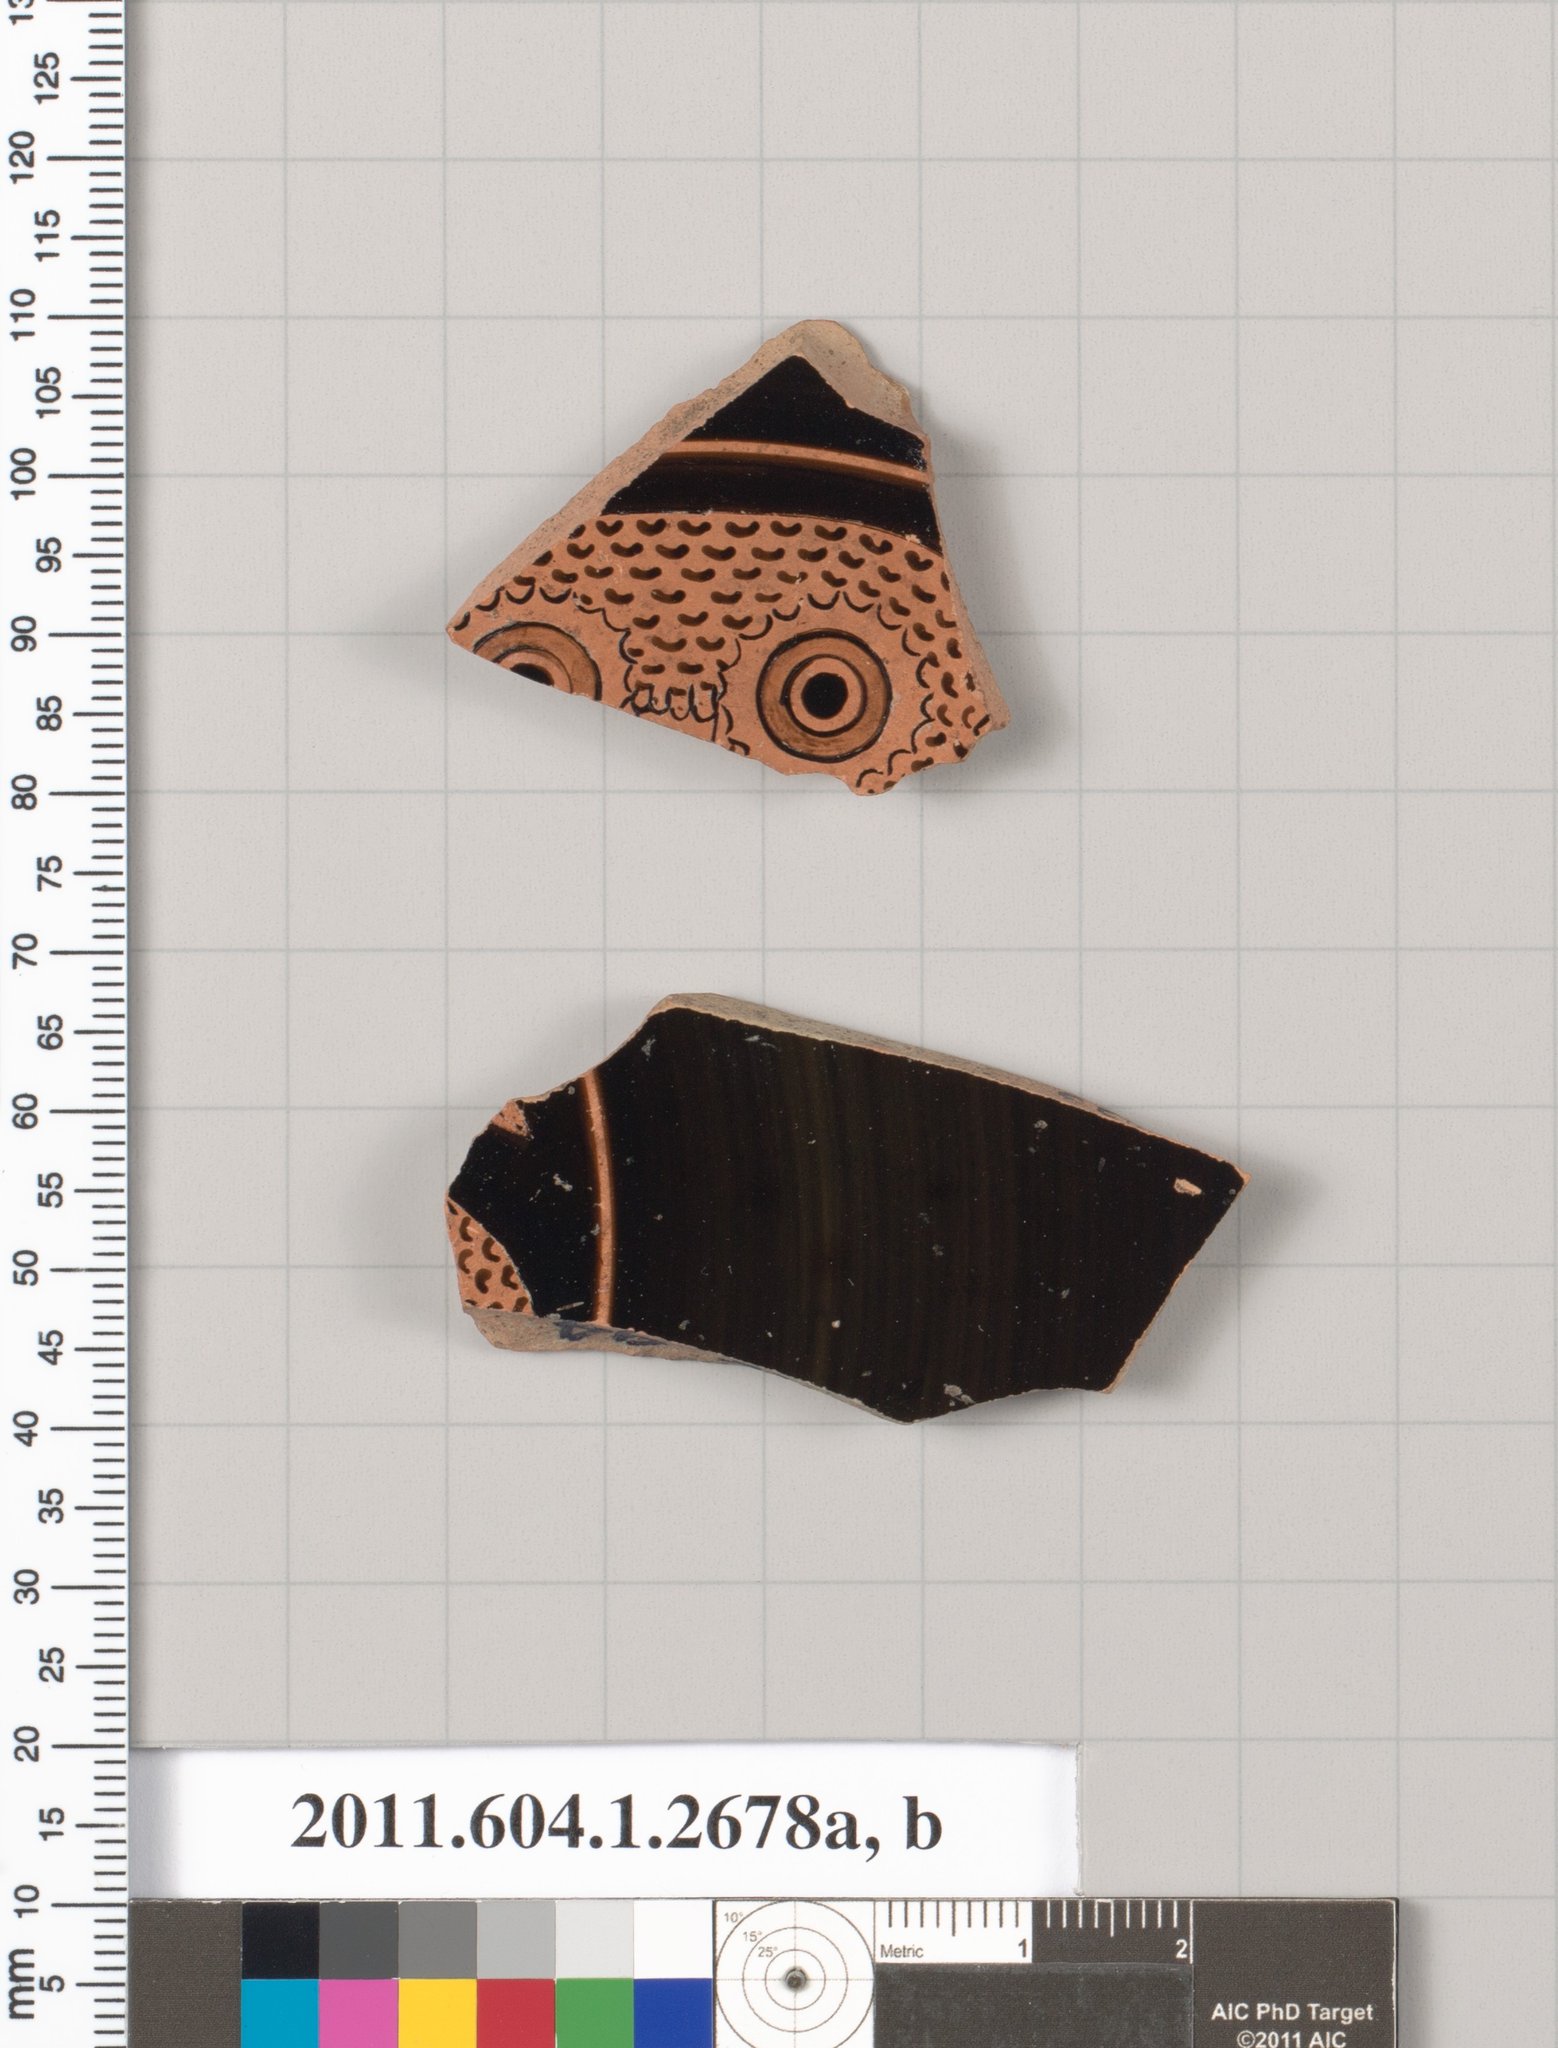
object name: kylix fragment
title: Terracotta fragments of a kylix (drinking cup)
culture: greek, attic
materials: terracotta